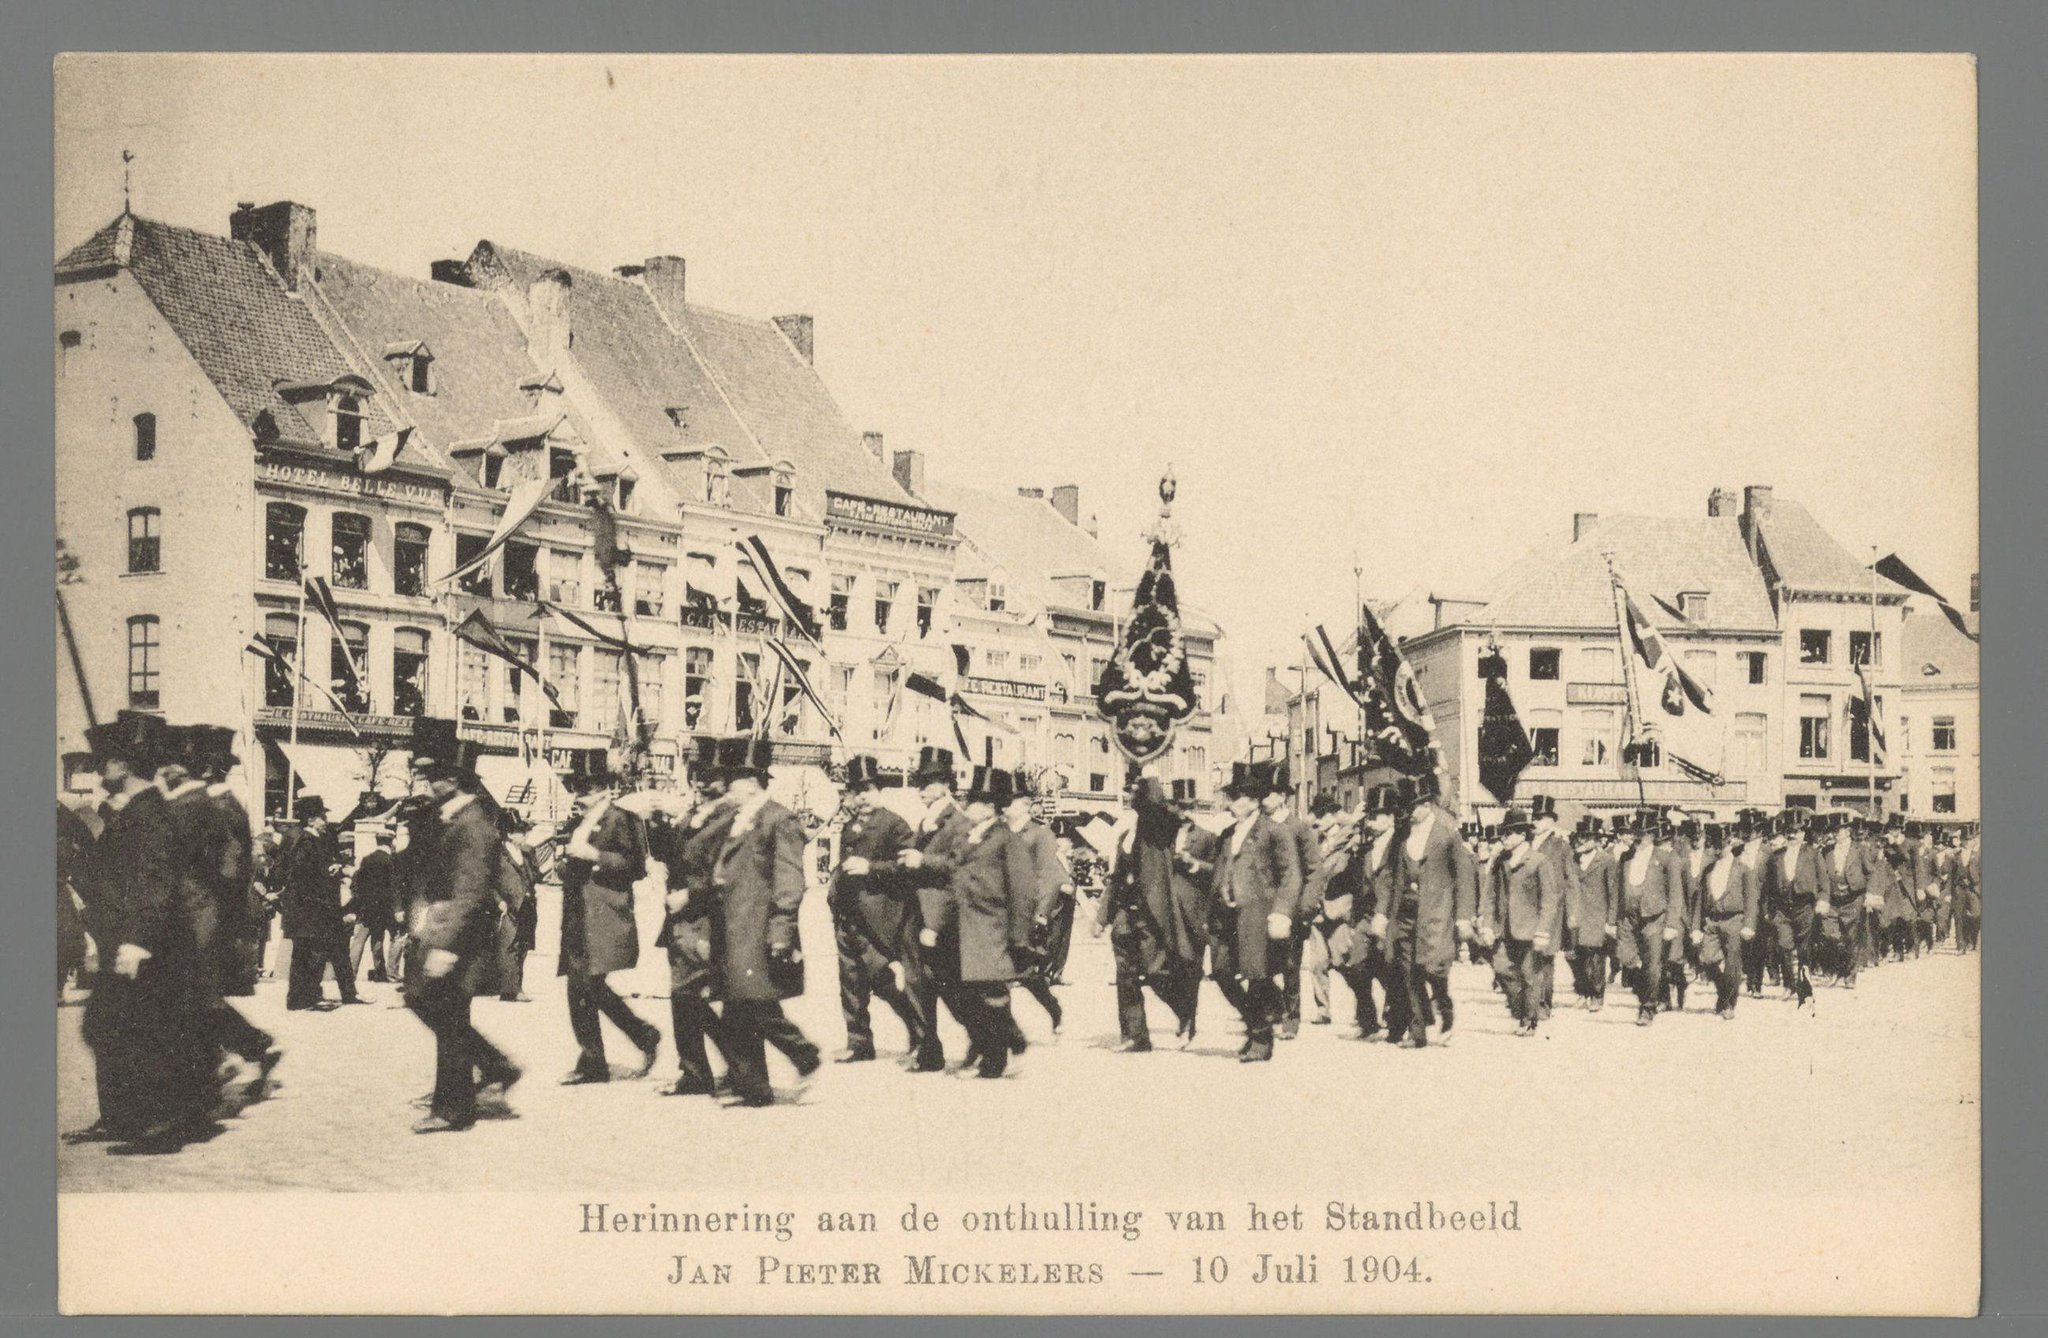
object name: ansichtkaart, prentbriefkaart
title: Herinnering aan de onthulling van het standbeeld Jan Pieter Mickelers - 10 juli 1904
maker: Anonymous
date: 1904-1905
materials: cardboard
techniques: photograph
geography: maastricht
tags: city-view, and landscape with man-made constructions, military parade, pageant, maastricht